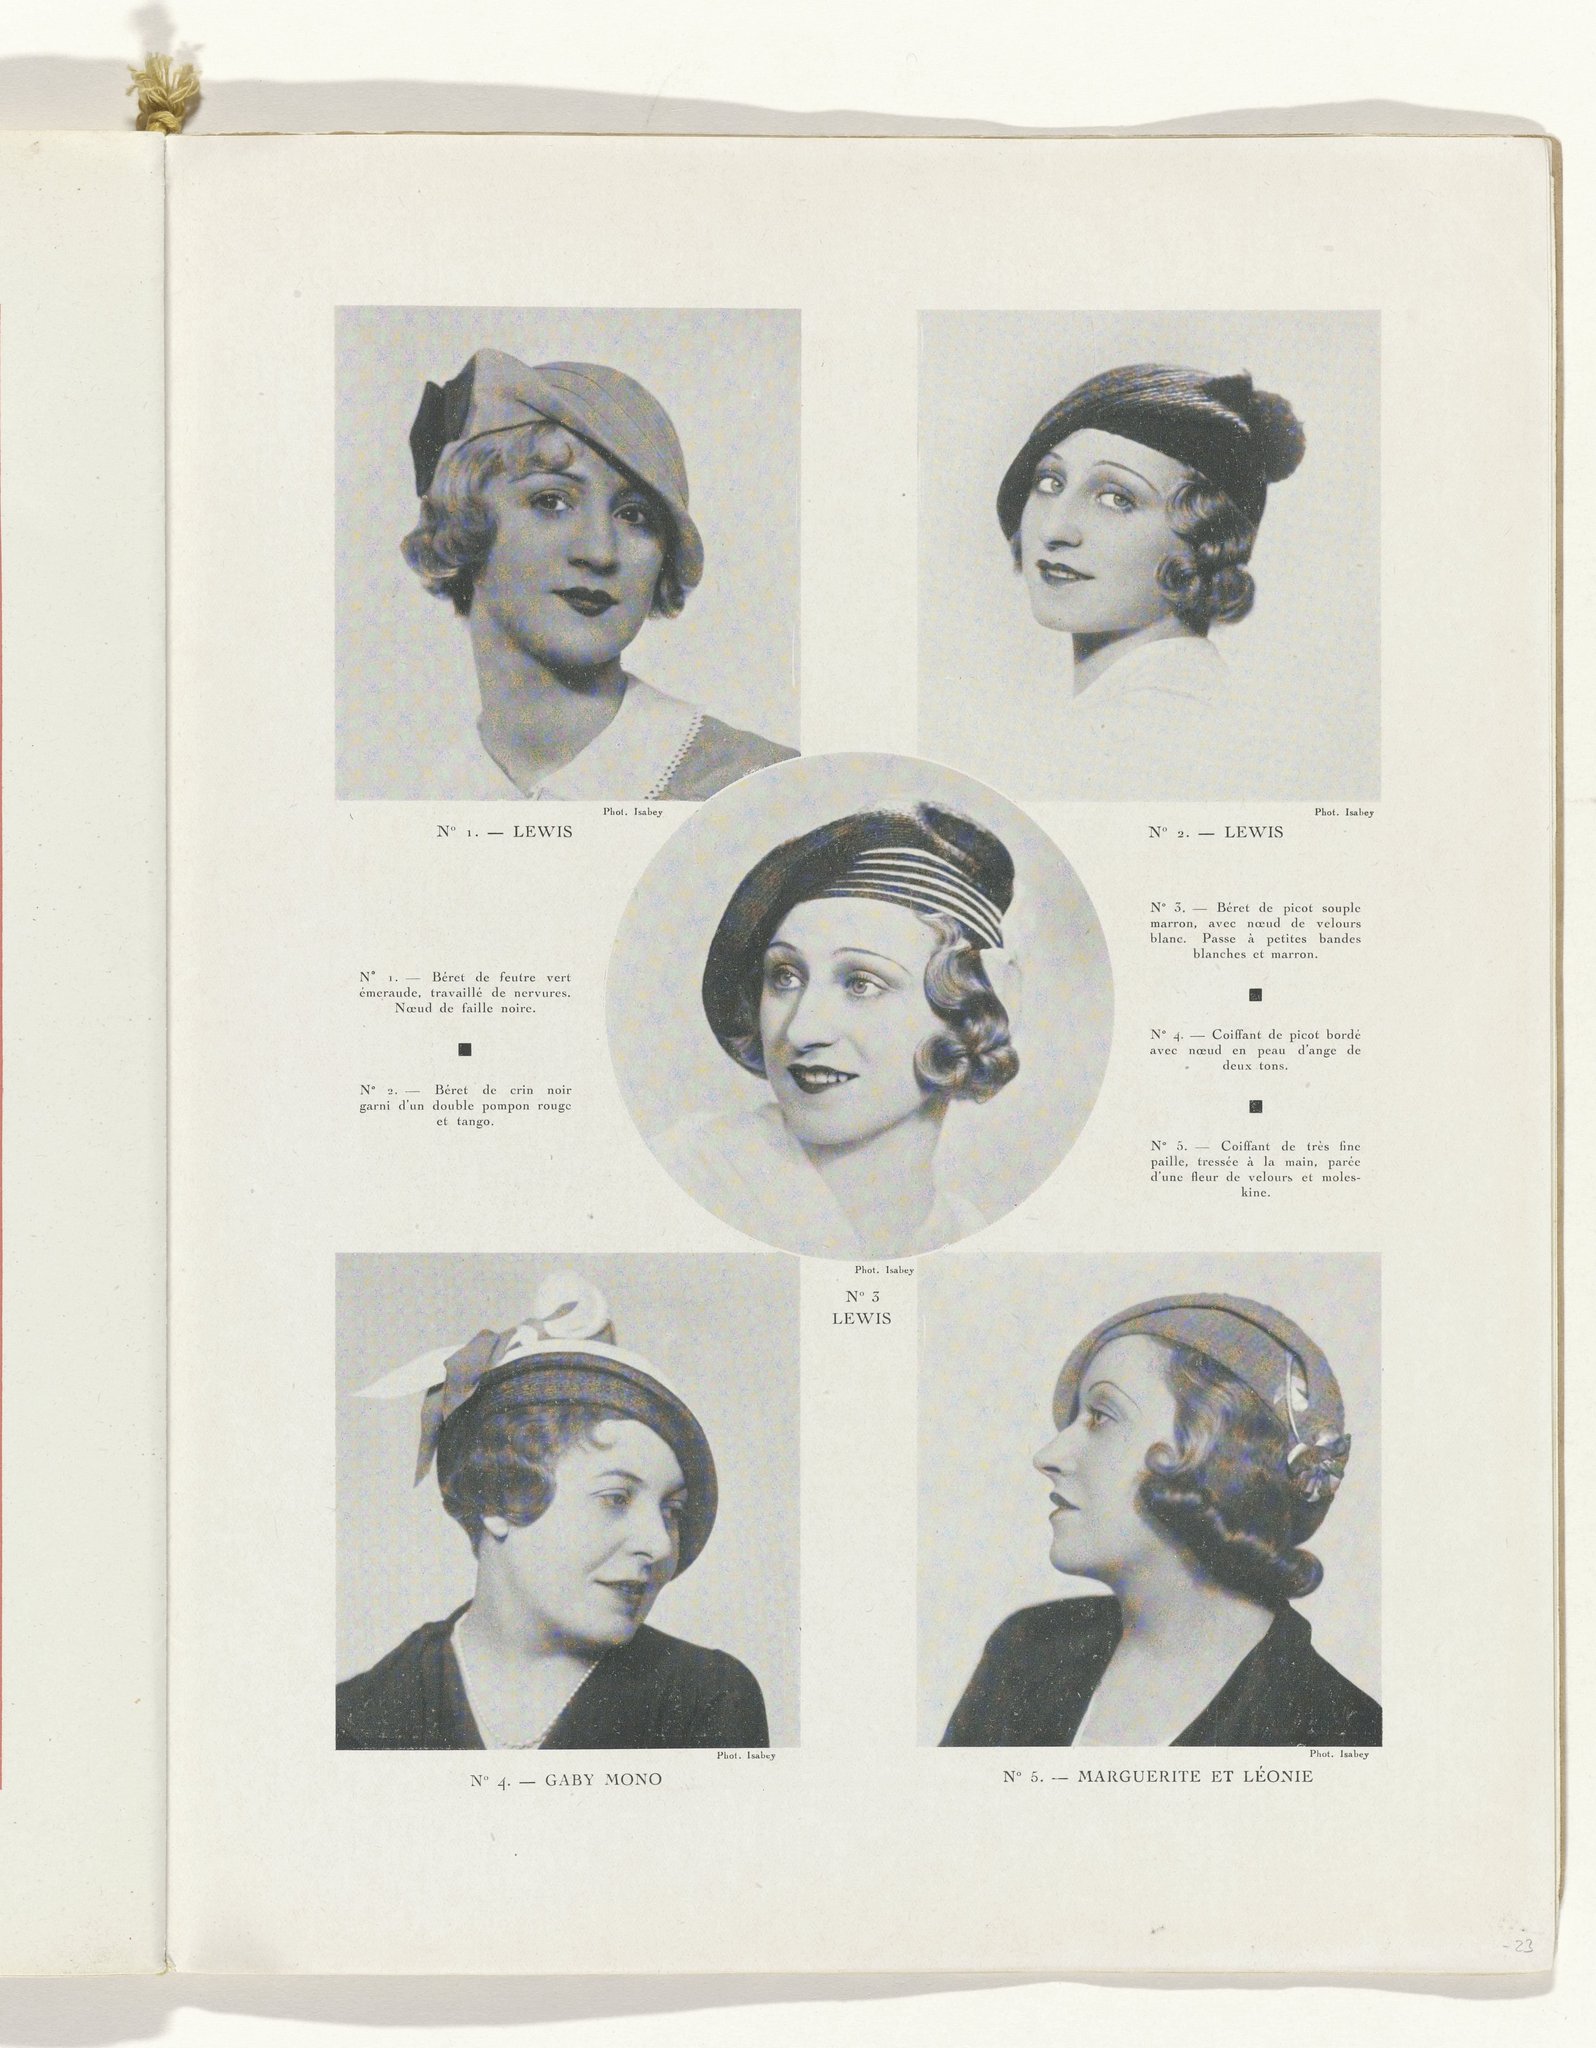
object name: magazine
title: Art - Goût - Beauté, Feuillets de l' élégance féminine, Mars 1932, No. 139, 12e Année, p. 23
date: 1932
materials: paper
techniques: photography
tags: head-gear: beret (+ women's clothes), fashion plates, head-gear: hat (+ women's clothes)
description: Vijf vrouwenhoofden met verschillende hoeden en baretten van Lewis, Gaby Mono en Marguerite et Léonie, genummerd 1 tot en met vijf. Pagina uit het modetijdschrift Art-Goût-Beauté (1920-1933).